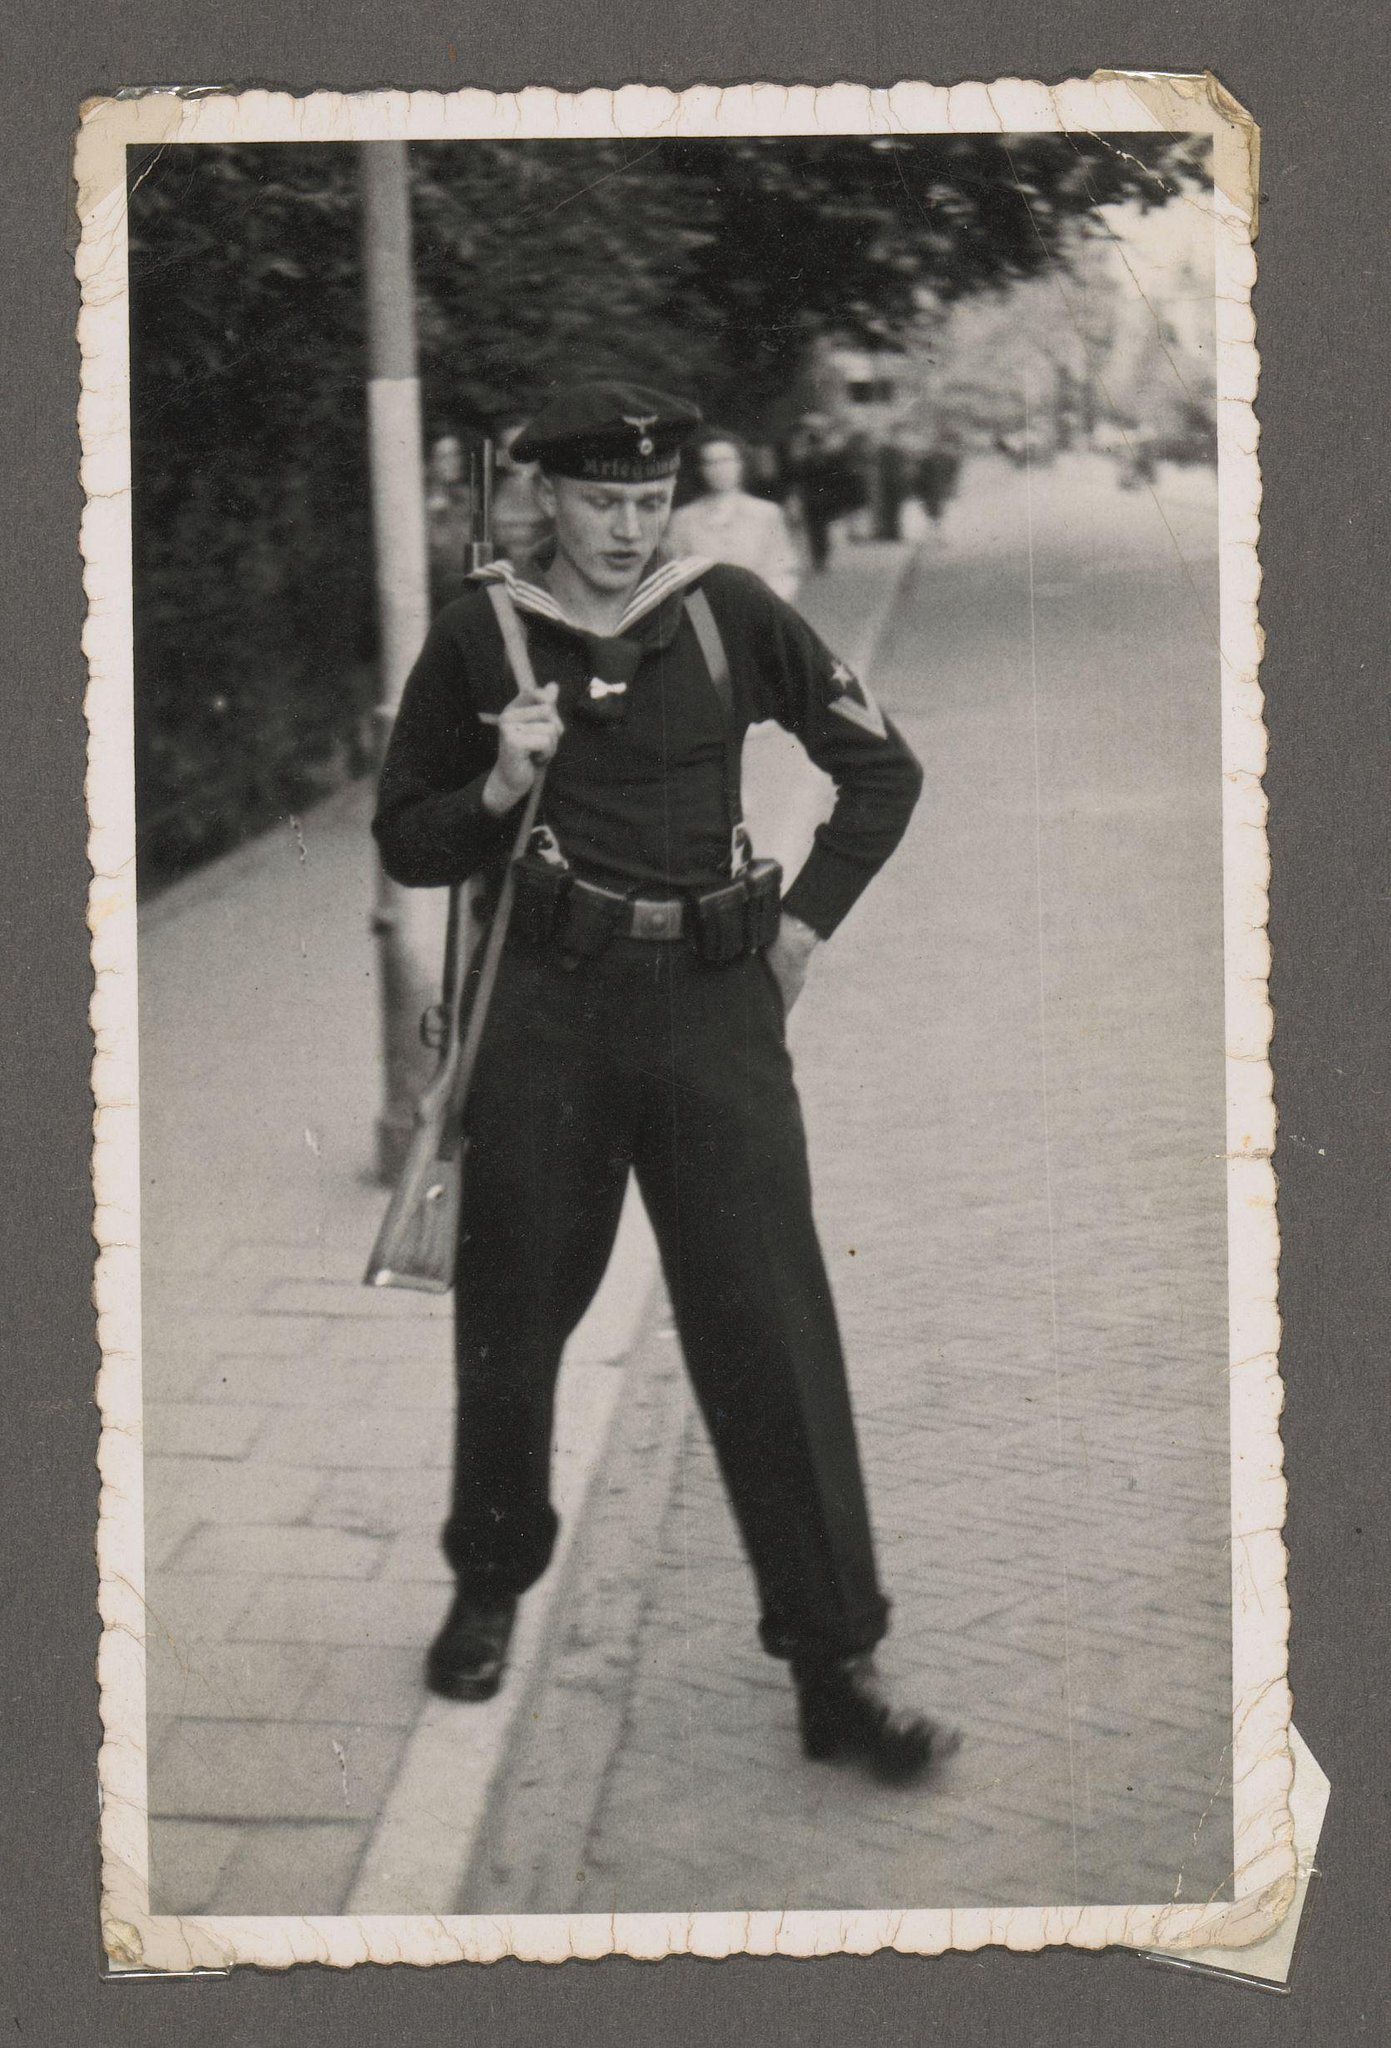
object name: album leaf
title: Portret van Heinrich Clausen in uniform op straat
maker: Anonymous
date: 1941-1945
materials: paper, photographic support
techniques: gelatin silver print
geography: kiel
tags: heinrich clausen, the soldier; the soldier's life, (military) uniforms, street